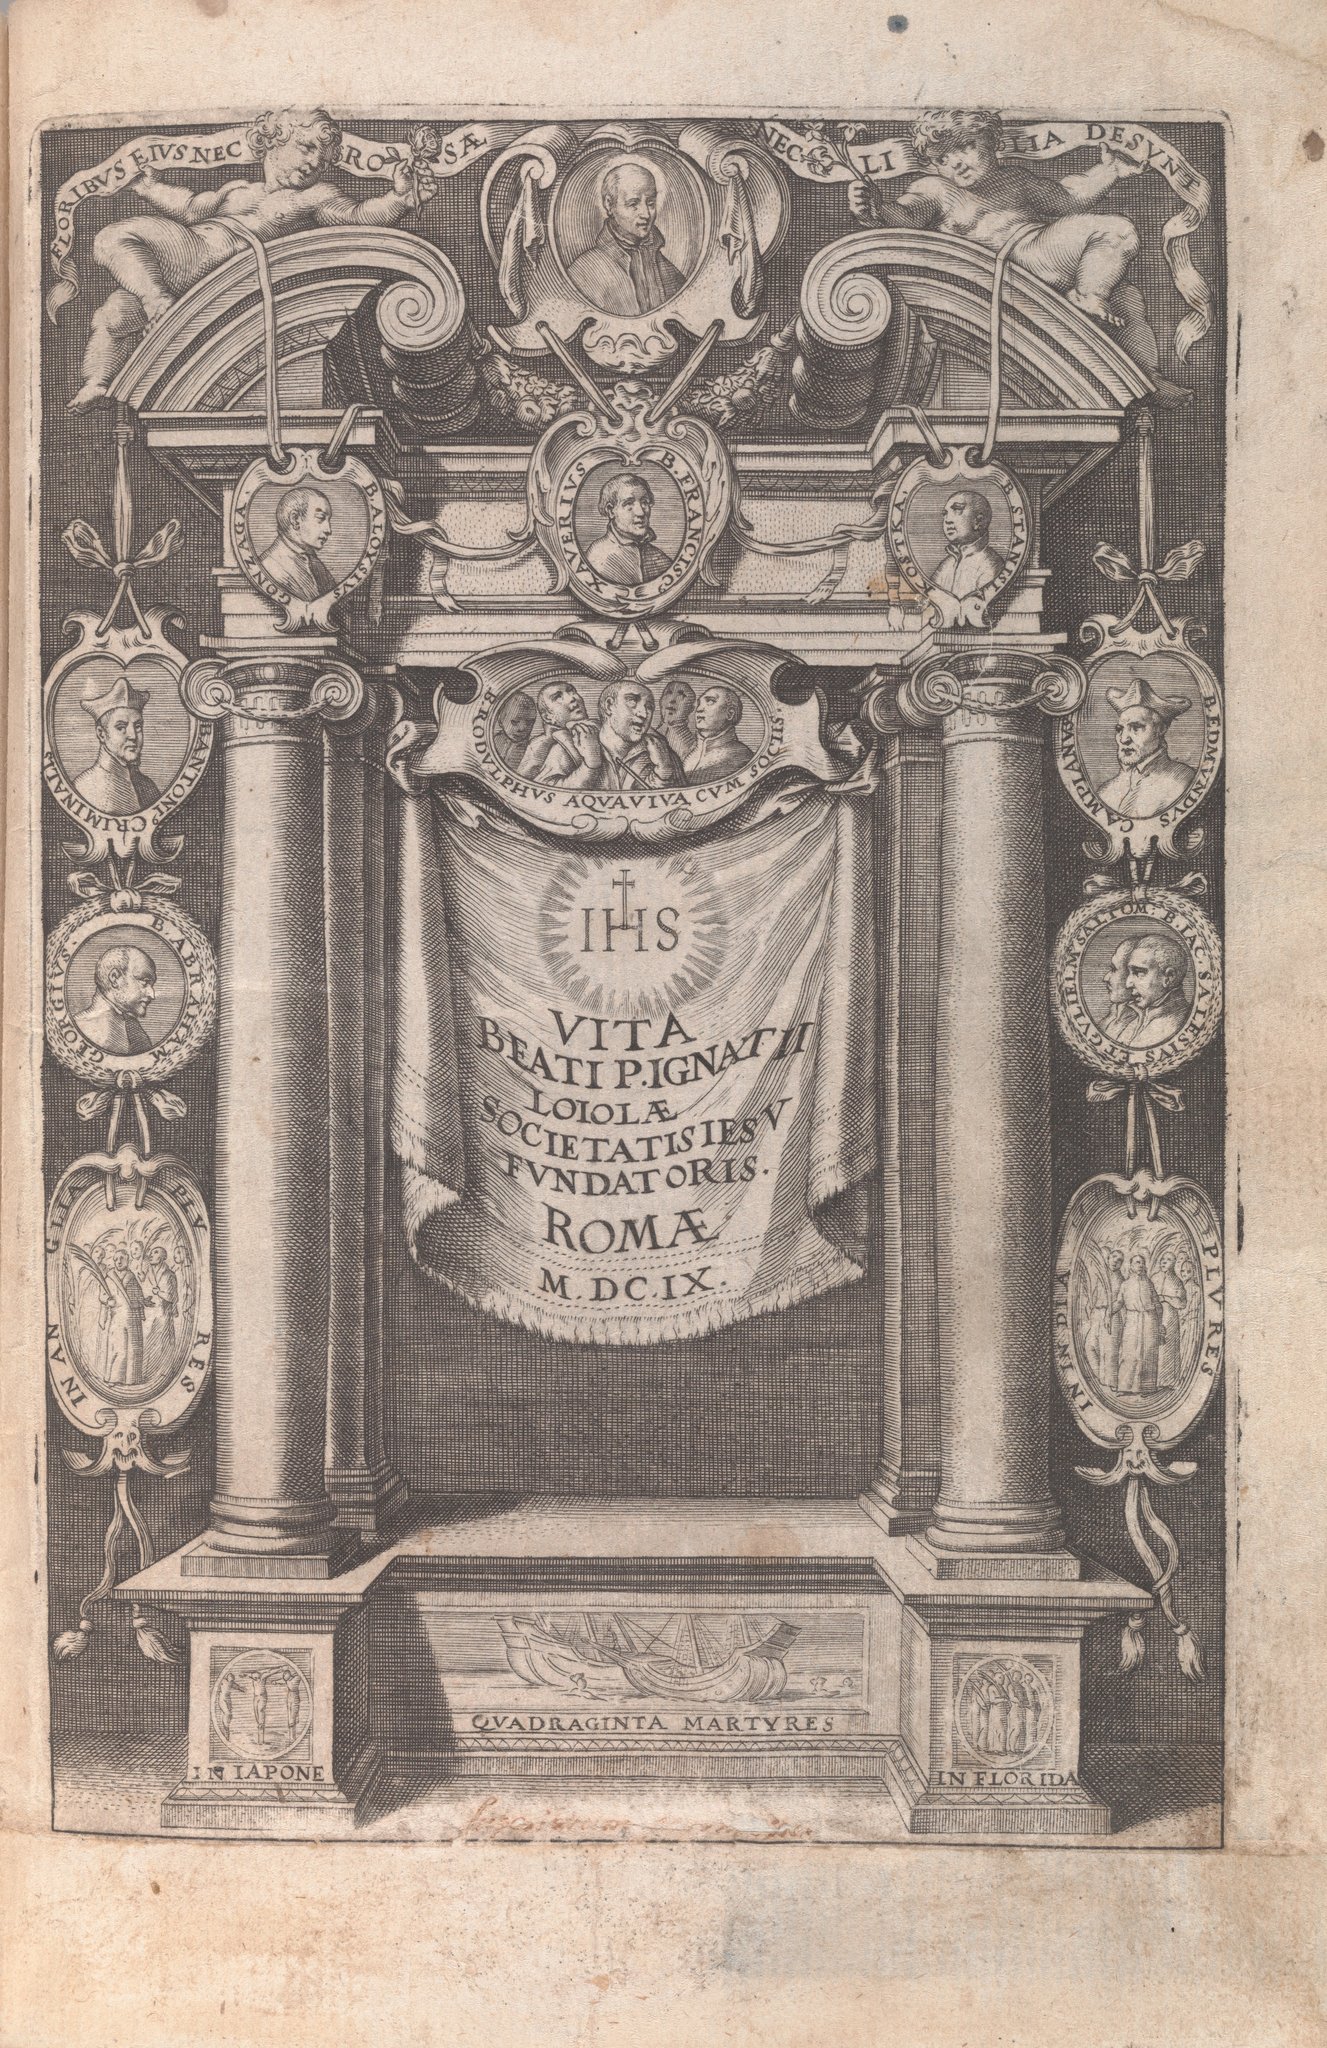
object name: book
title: Vita Beati P. Ignatii Loiolae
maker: saint ignatius of loyola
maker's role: author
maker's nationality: spanish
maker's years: 1491-1556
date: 1609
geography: rome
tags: columns,men,portraits